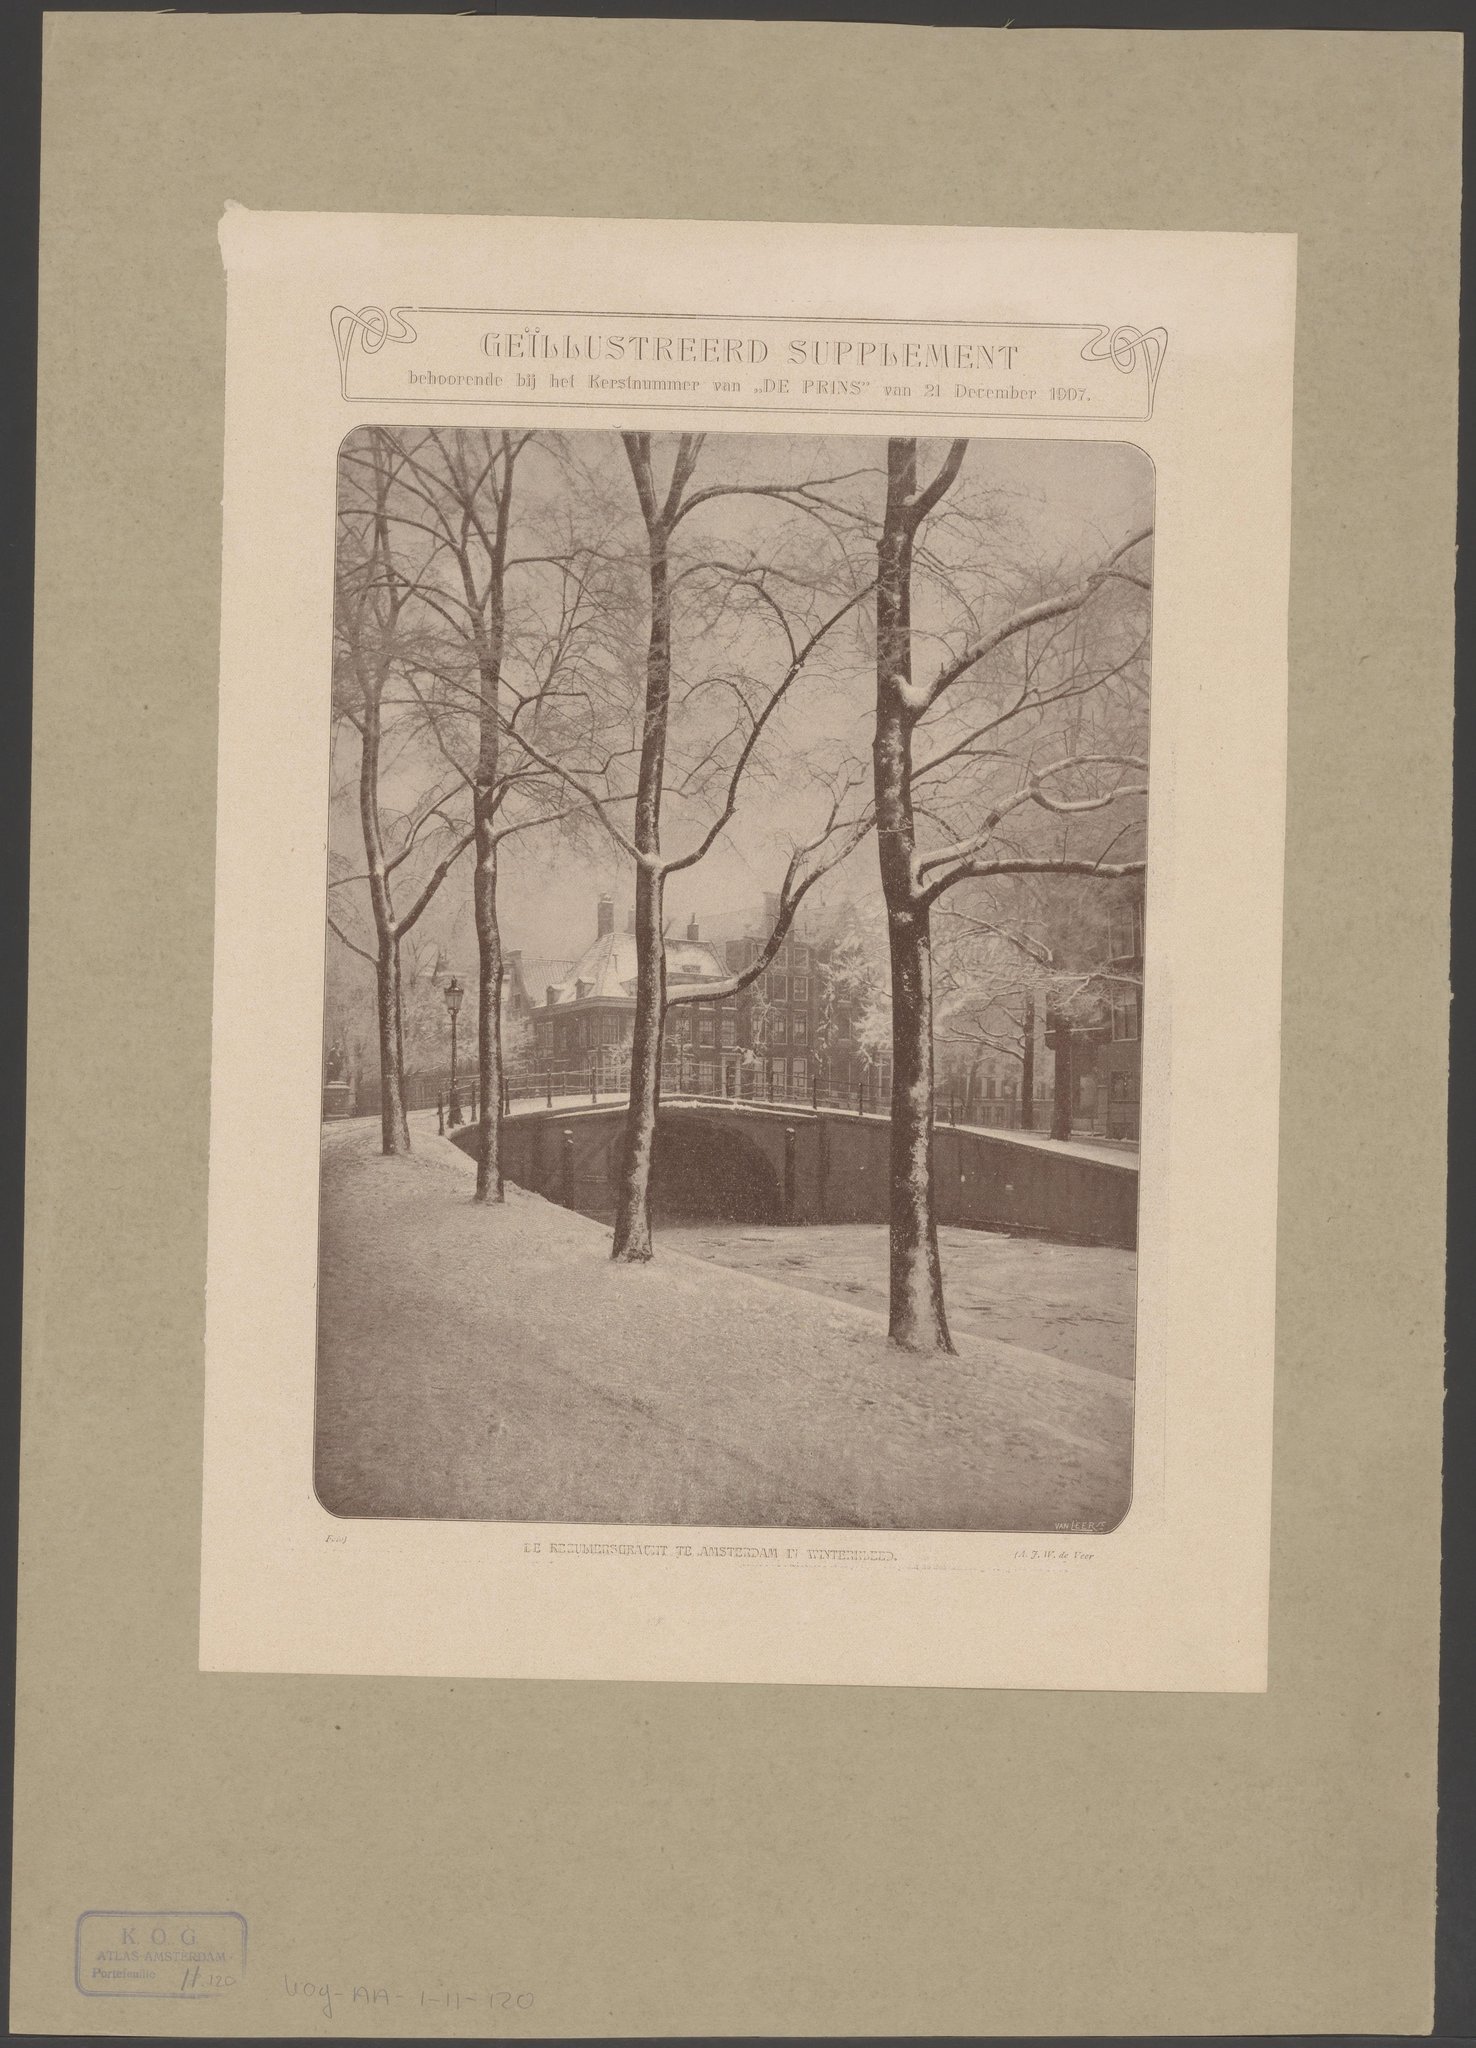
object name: photomechanical print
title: Wintergezicht op de Reguliersgracht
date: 1907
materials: paper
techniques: autotype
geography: amsterdam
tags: city-view in general; 'veduta', canal, winter landscape; landscape symbolizing winter (the four seasons of the year), bridge in city across river, canal, etc.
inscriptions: collector's mark: ‘11.120’ Lugt 1641b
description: Onderwerpsrubriek binnen de Atlas Amsterdam: Raadhuisstraat, Raamgracht, Raamplein, Rapenburgerstraat, Reguliersgracht, Reguliersbreestraat.